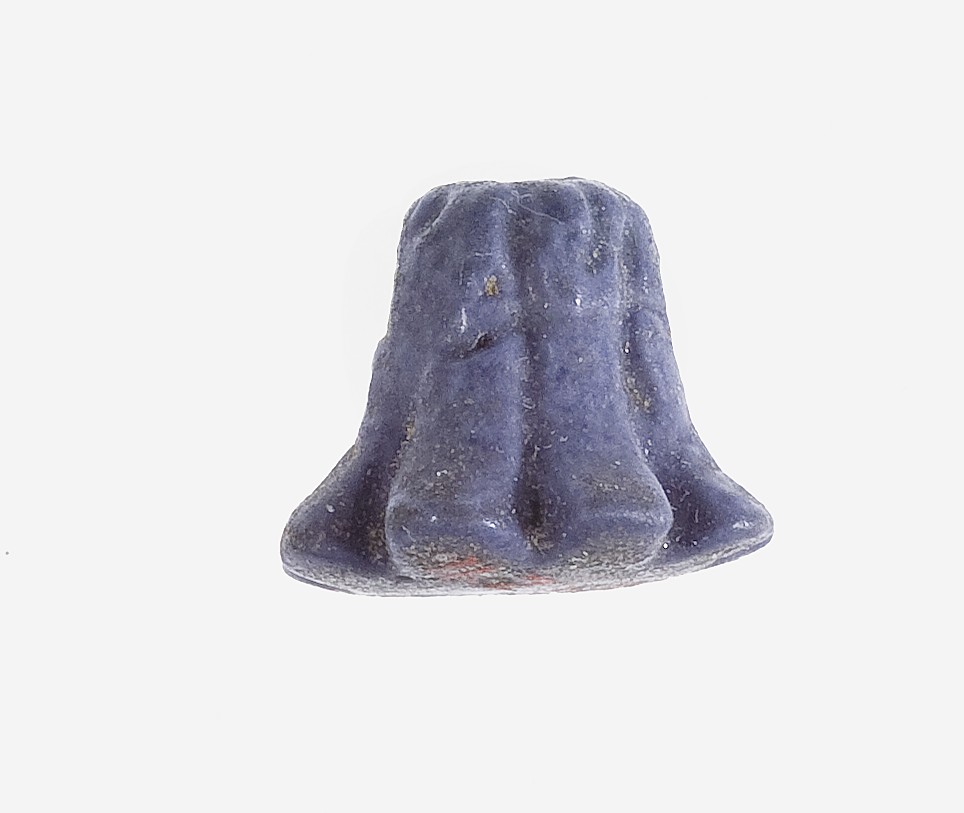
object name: pendant, cornflower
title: Petalsof a Composite Cornflower Pendant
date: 1390-1352 BCE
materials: faience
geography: egypt